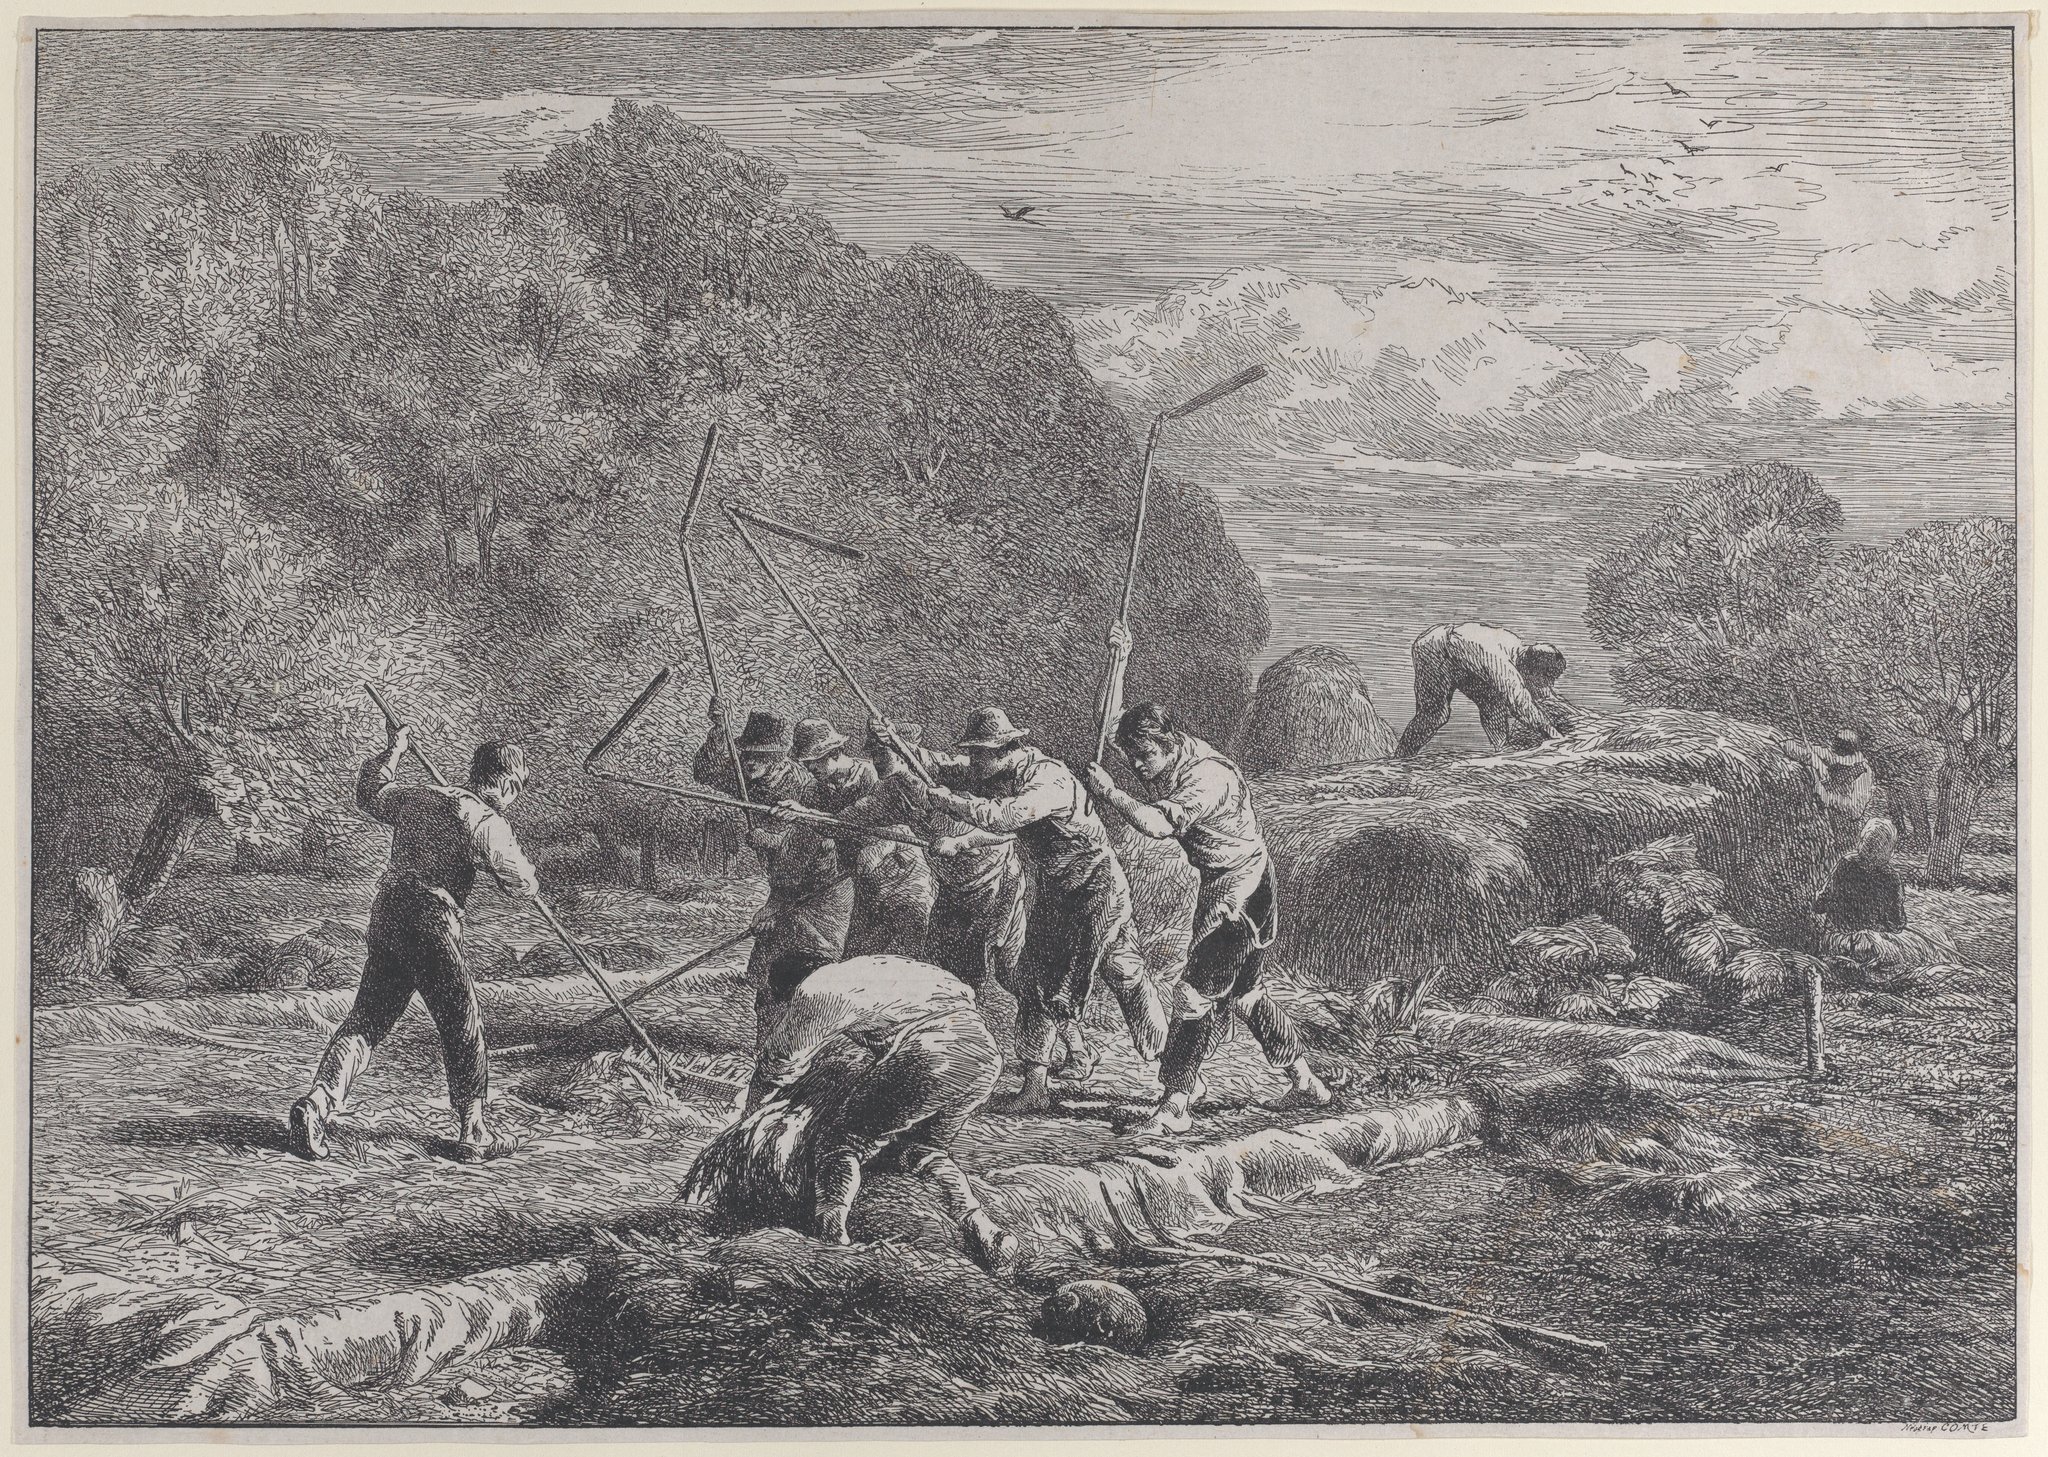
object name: print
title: Men thrashing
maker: Anonymous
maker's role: artist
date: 1800-1900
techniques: etching